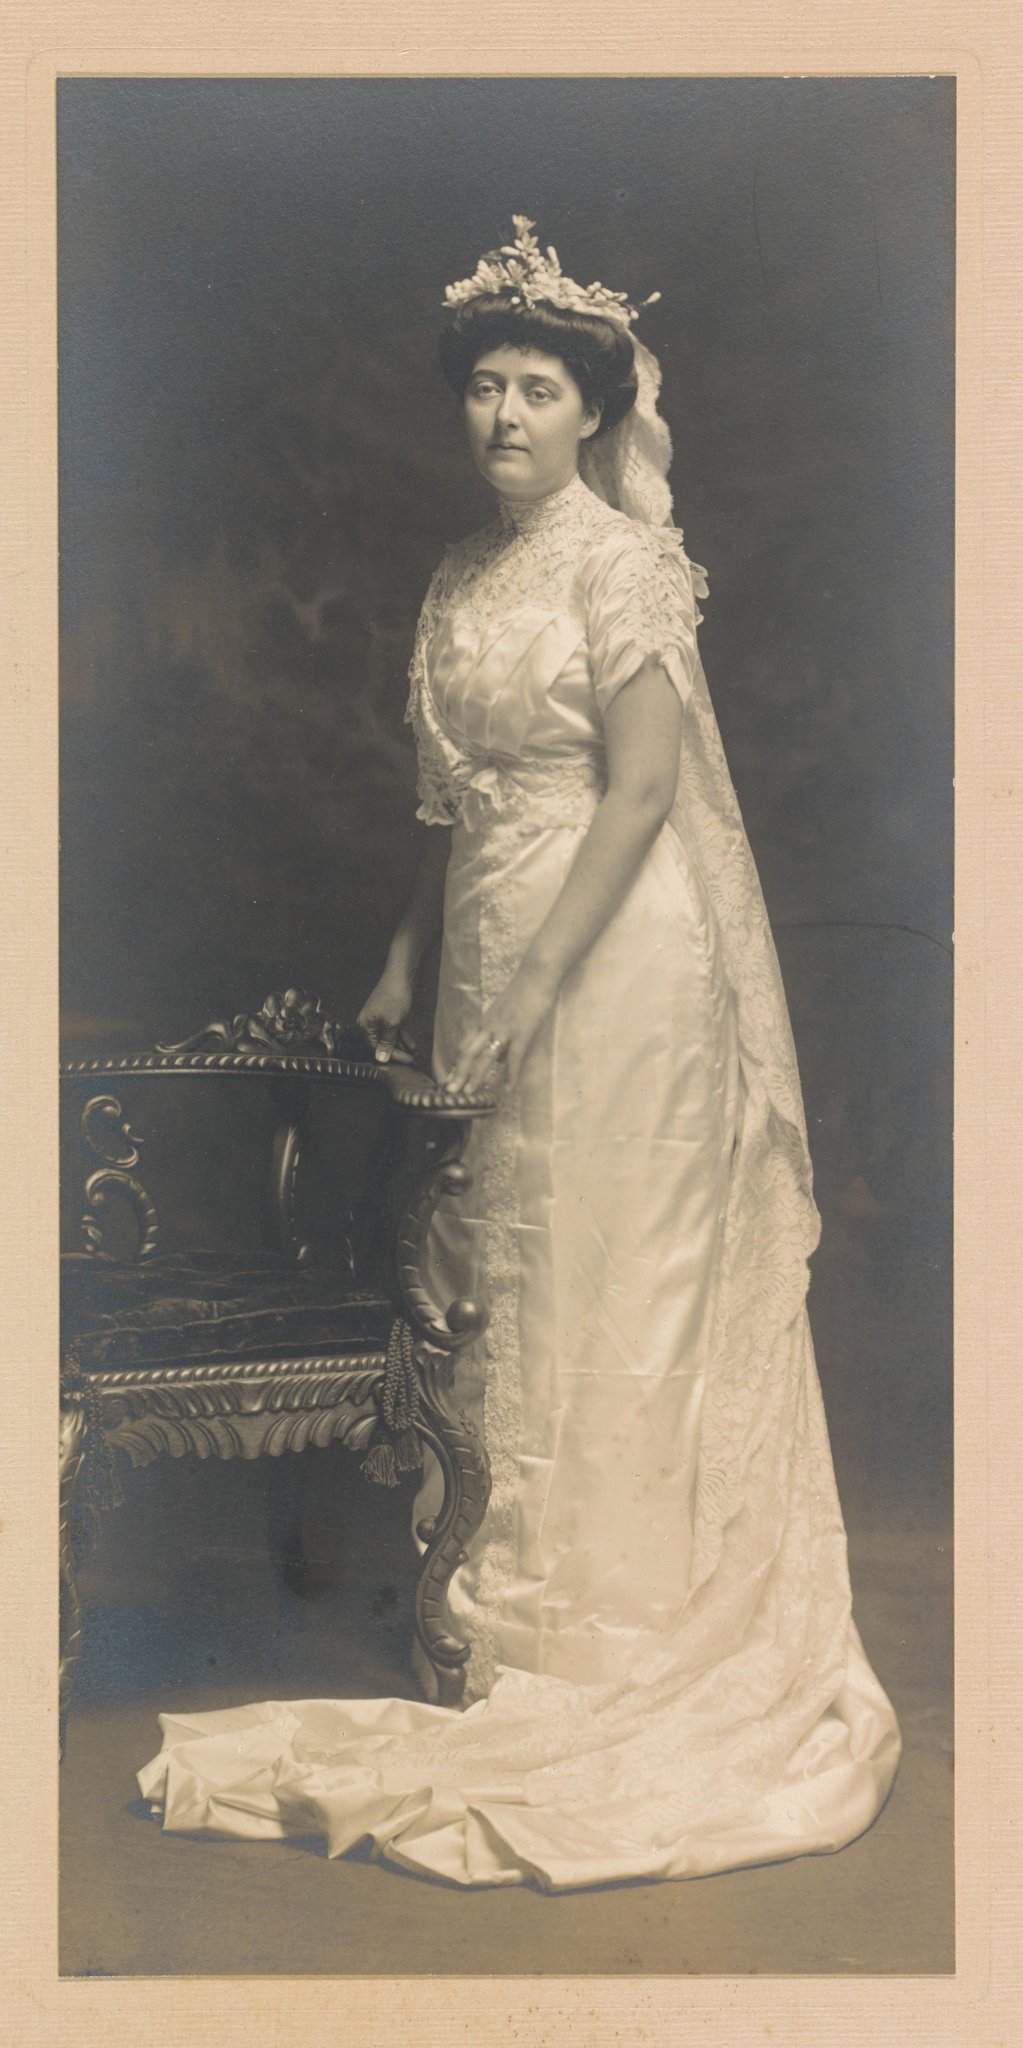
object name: photograph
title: Portret van een bruid in een lange jurk met sleep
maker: Anonymous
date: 1900-1920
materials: cardboard, photographic support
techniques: gelatin silver print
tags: bride (in wedding-dress), dress, gown